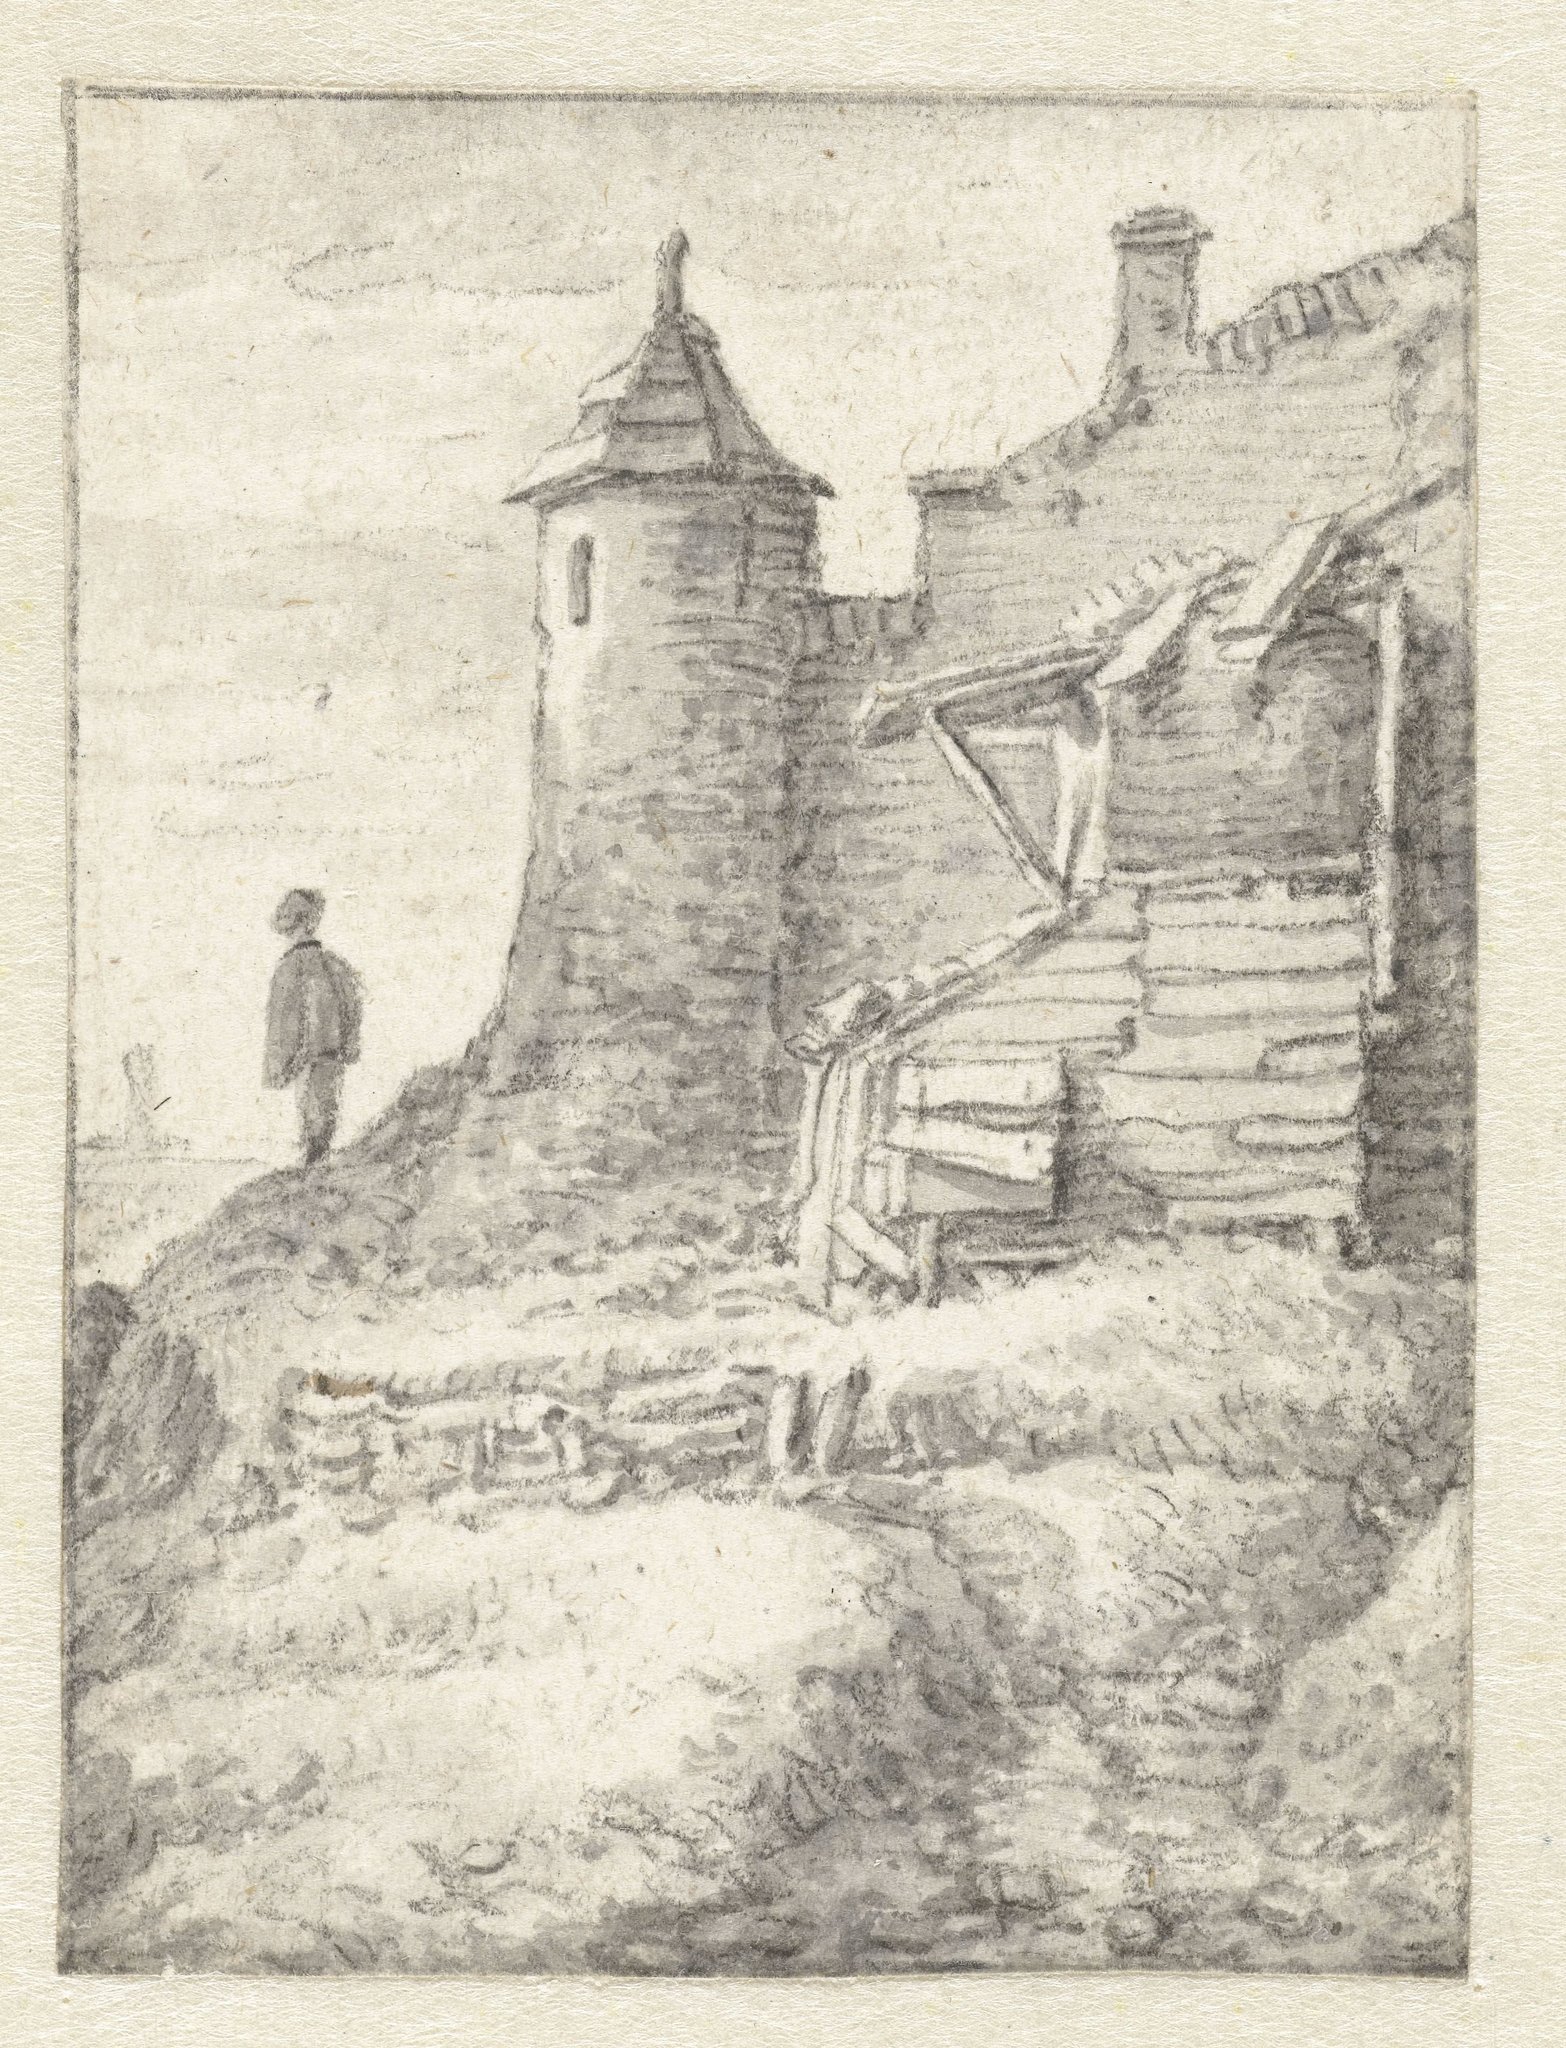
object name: drawing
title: Gezicht op een stadswal met toren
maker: herman saftleven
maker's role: draughtsman, painter, print maker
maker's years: 1609-1685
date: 1619-1685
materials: chalk, paper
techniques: brush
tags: city-walls